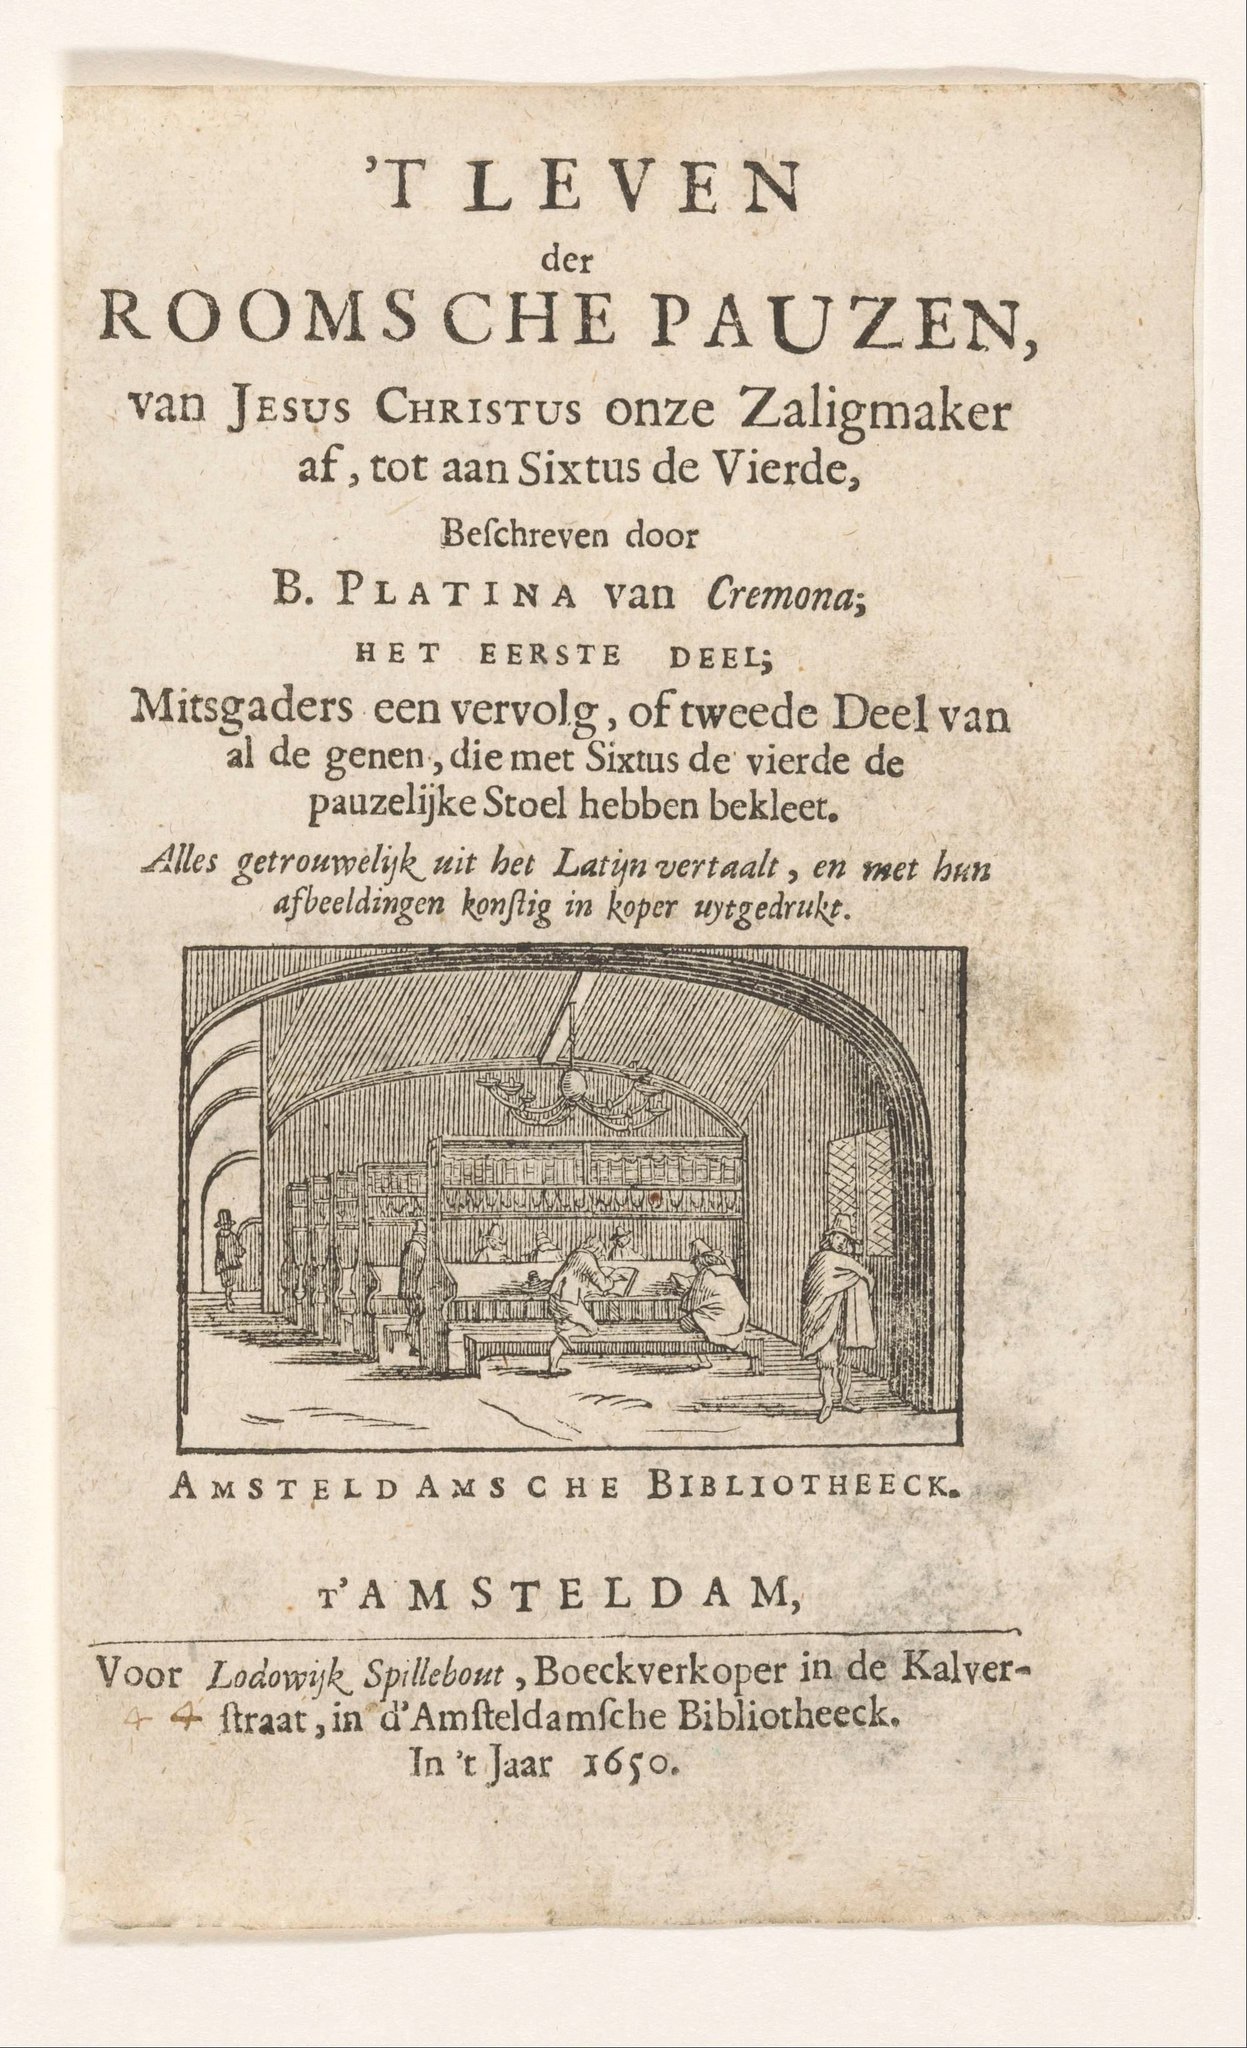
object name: titelblad, titelpagina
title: Bibliotheek van Amsterdam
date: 1650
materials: paper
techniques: letterpress printing, engraving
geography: amsterdam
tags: reading, public library, amsterdam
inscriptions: collector's mark: Lugt 2760, collector's mark: Lugt 2228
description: Lezende mannen aan tafel in de stads- en athenaeumbibliotheek van Amsterdam omstreeks 1650. Gebruikt als drukkersmerk door boekhandelaar en uitgever Lodewijk Spillebout.